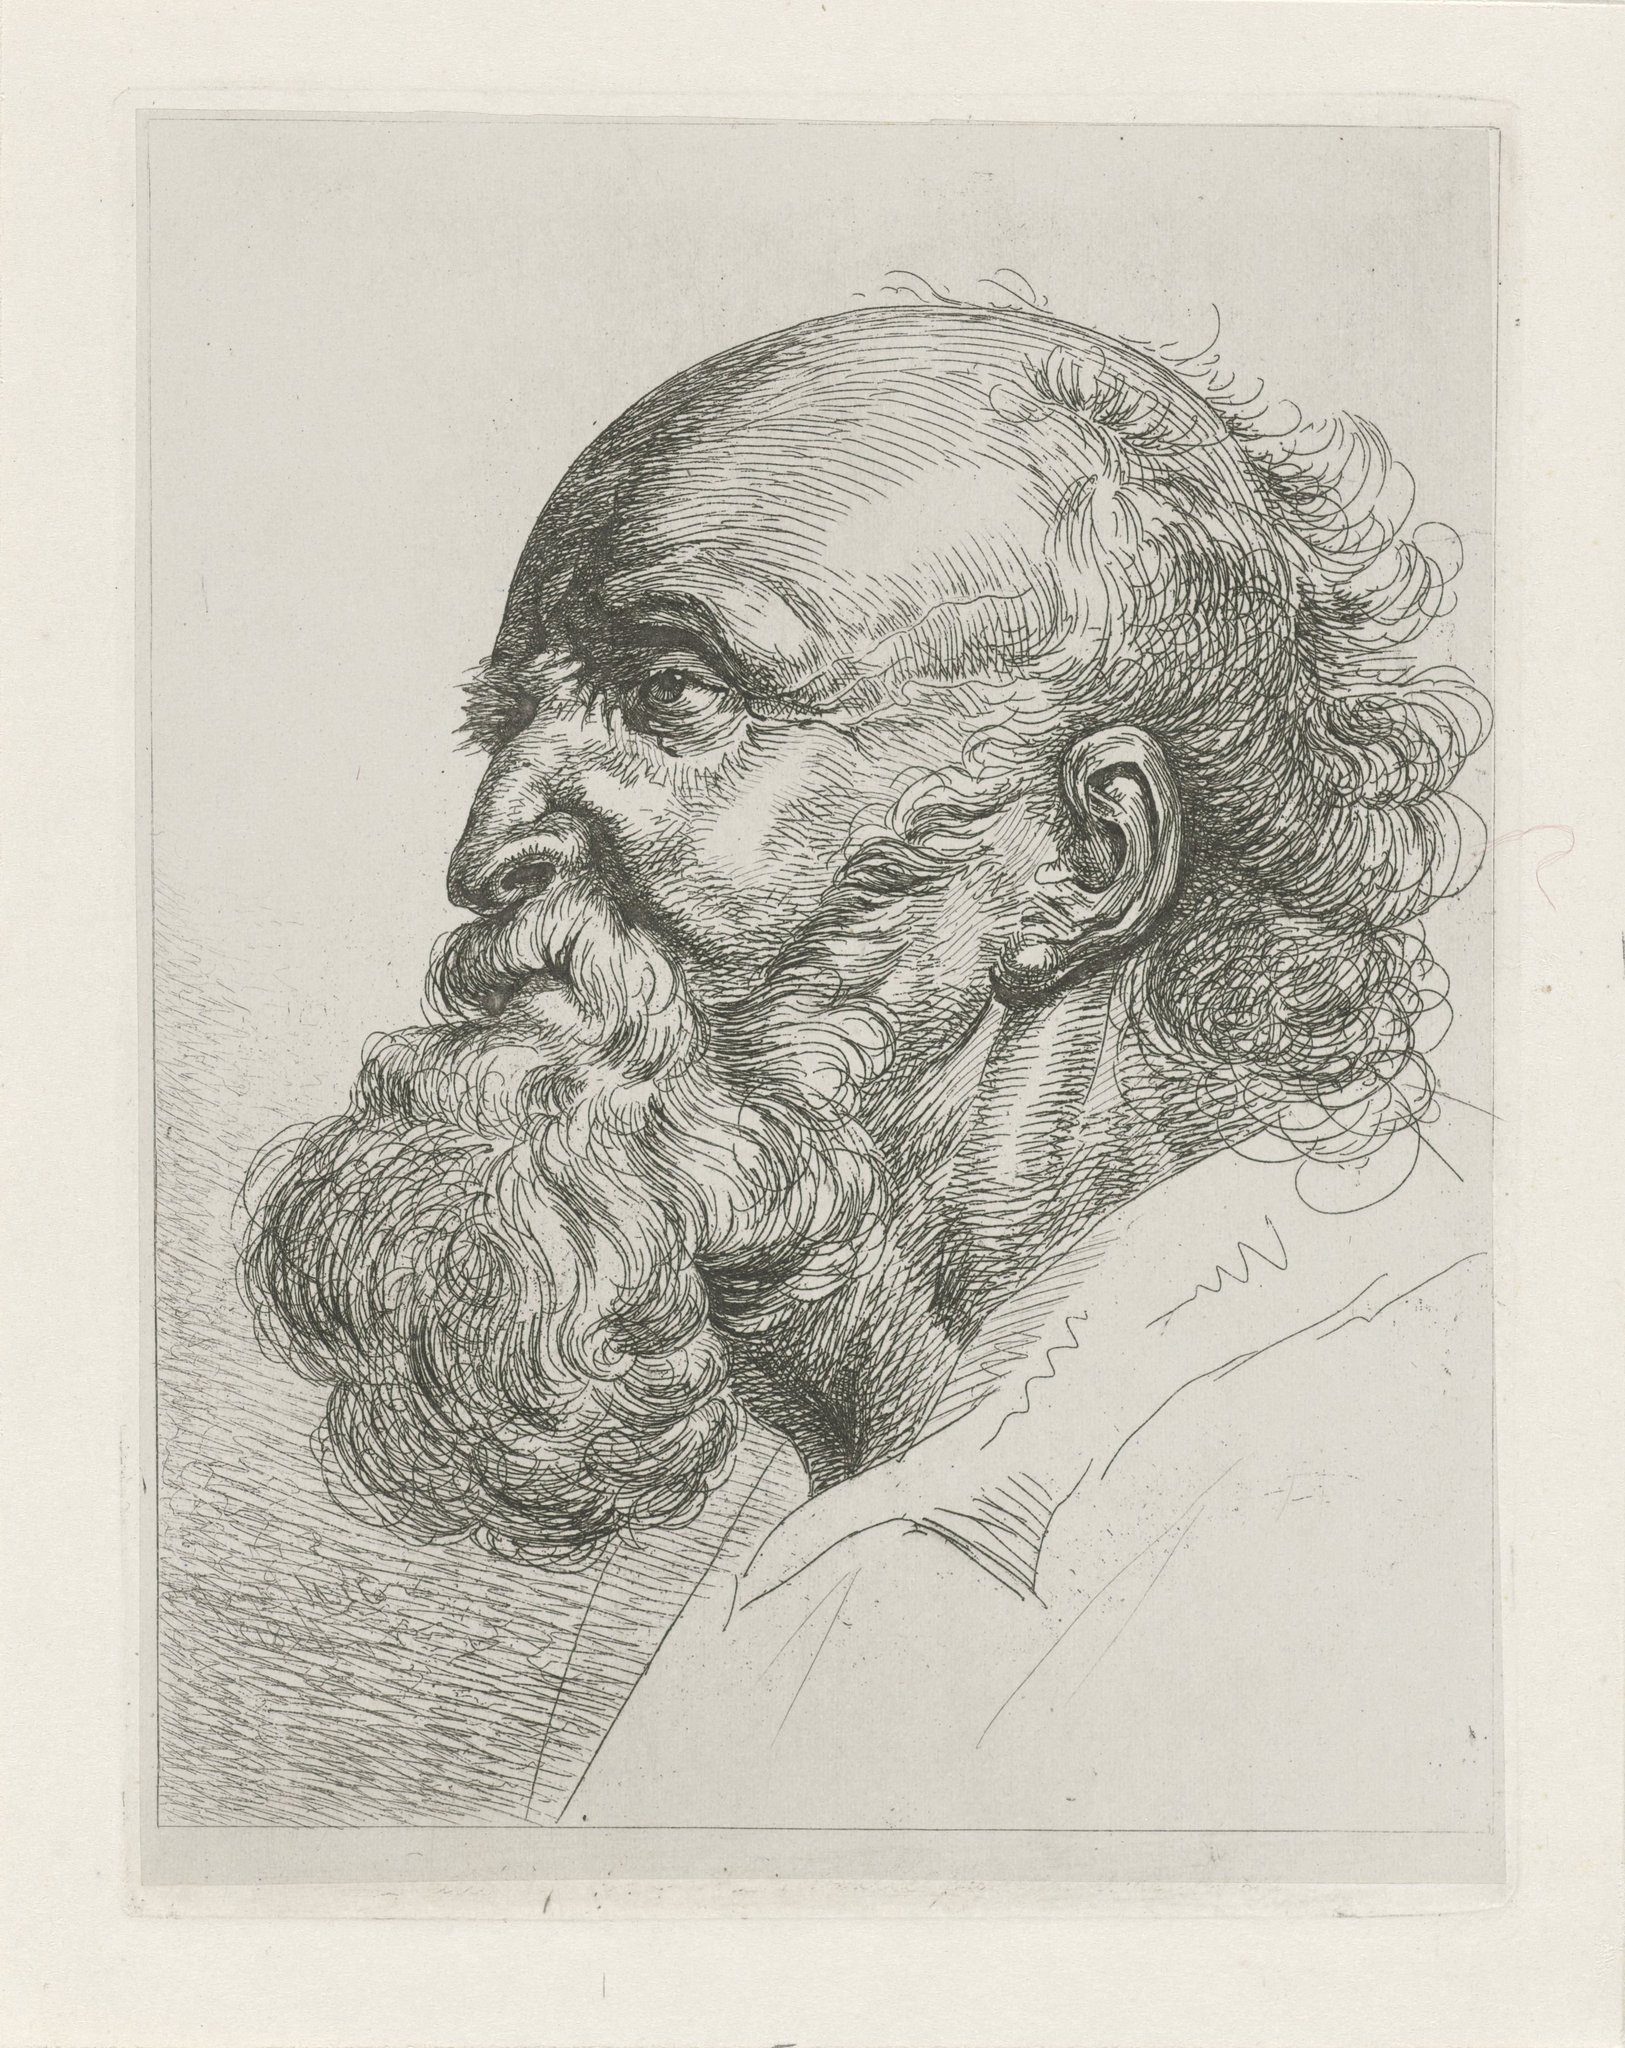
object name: print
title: Portret van een oude man met baard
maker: jean zacherie mazel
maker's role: draughtsman, print maker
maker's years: 1792-1884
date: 1812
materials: paper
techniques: etching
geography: netherlands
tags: old man, beard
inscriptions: collector's mark: Lugt 2233